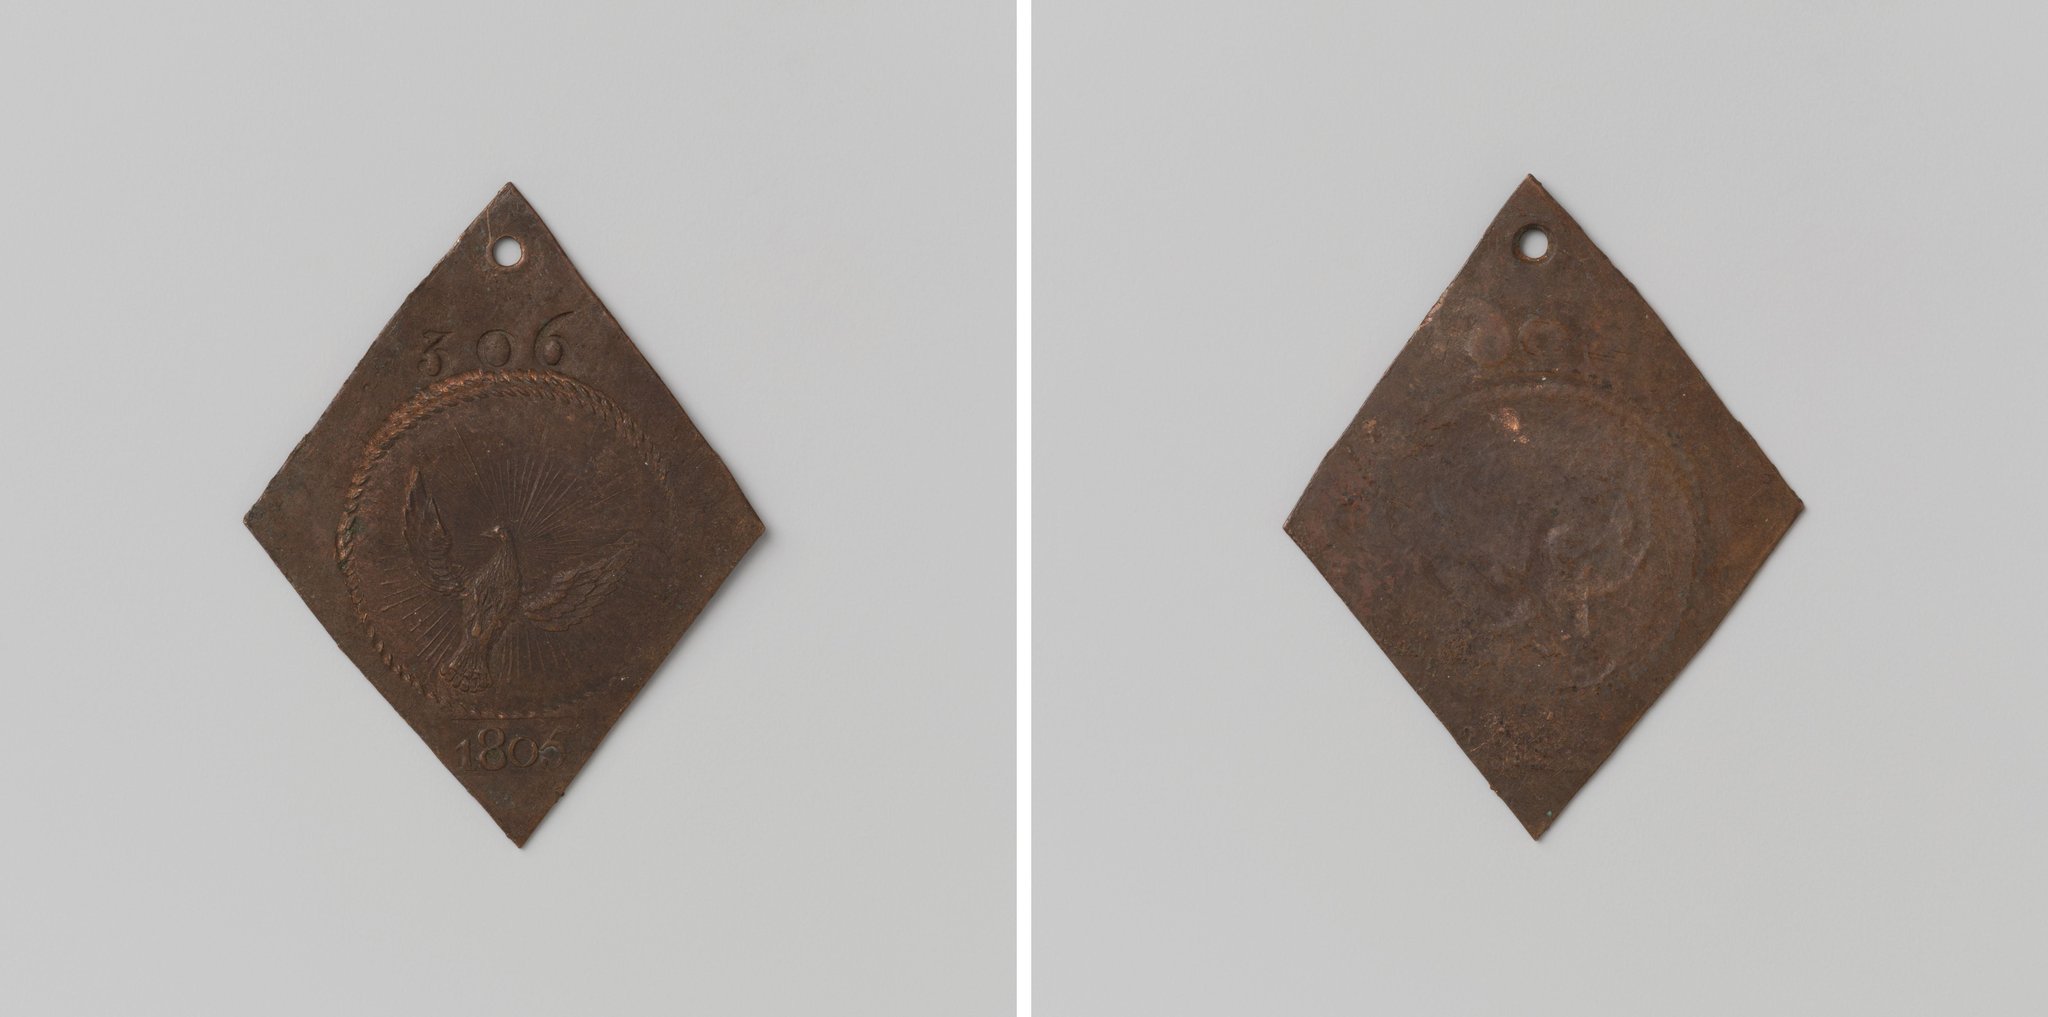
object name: hondenbelastingloodje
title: Geefhuis te Gouda, armeloodje met no. 306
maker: Anonymous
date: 1805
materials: copper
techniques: striking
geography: gouda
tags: gouda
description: Eenzijdig koperen ruitvormig loodje met gat erin. Voorzijde: in ovale sierrand: duif met gespreide vleugels in stralenkrans; boven sierrand: cijfer 306, eronder: jaartal in compartiment. Keerzijde: blanco.